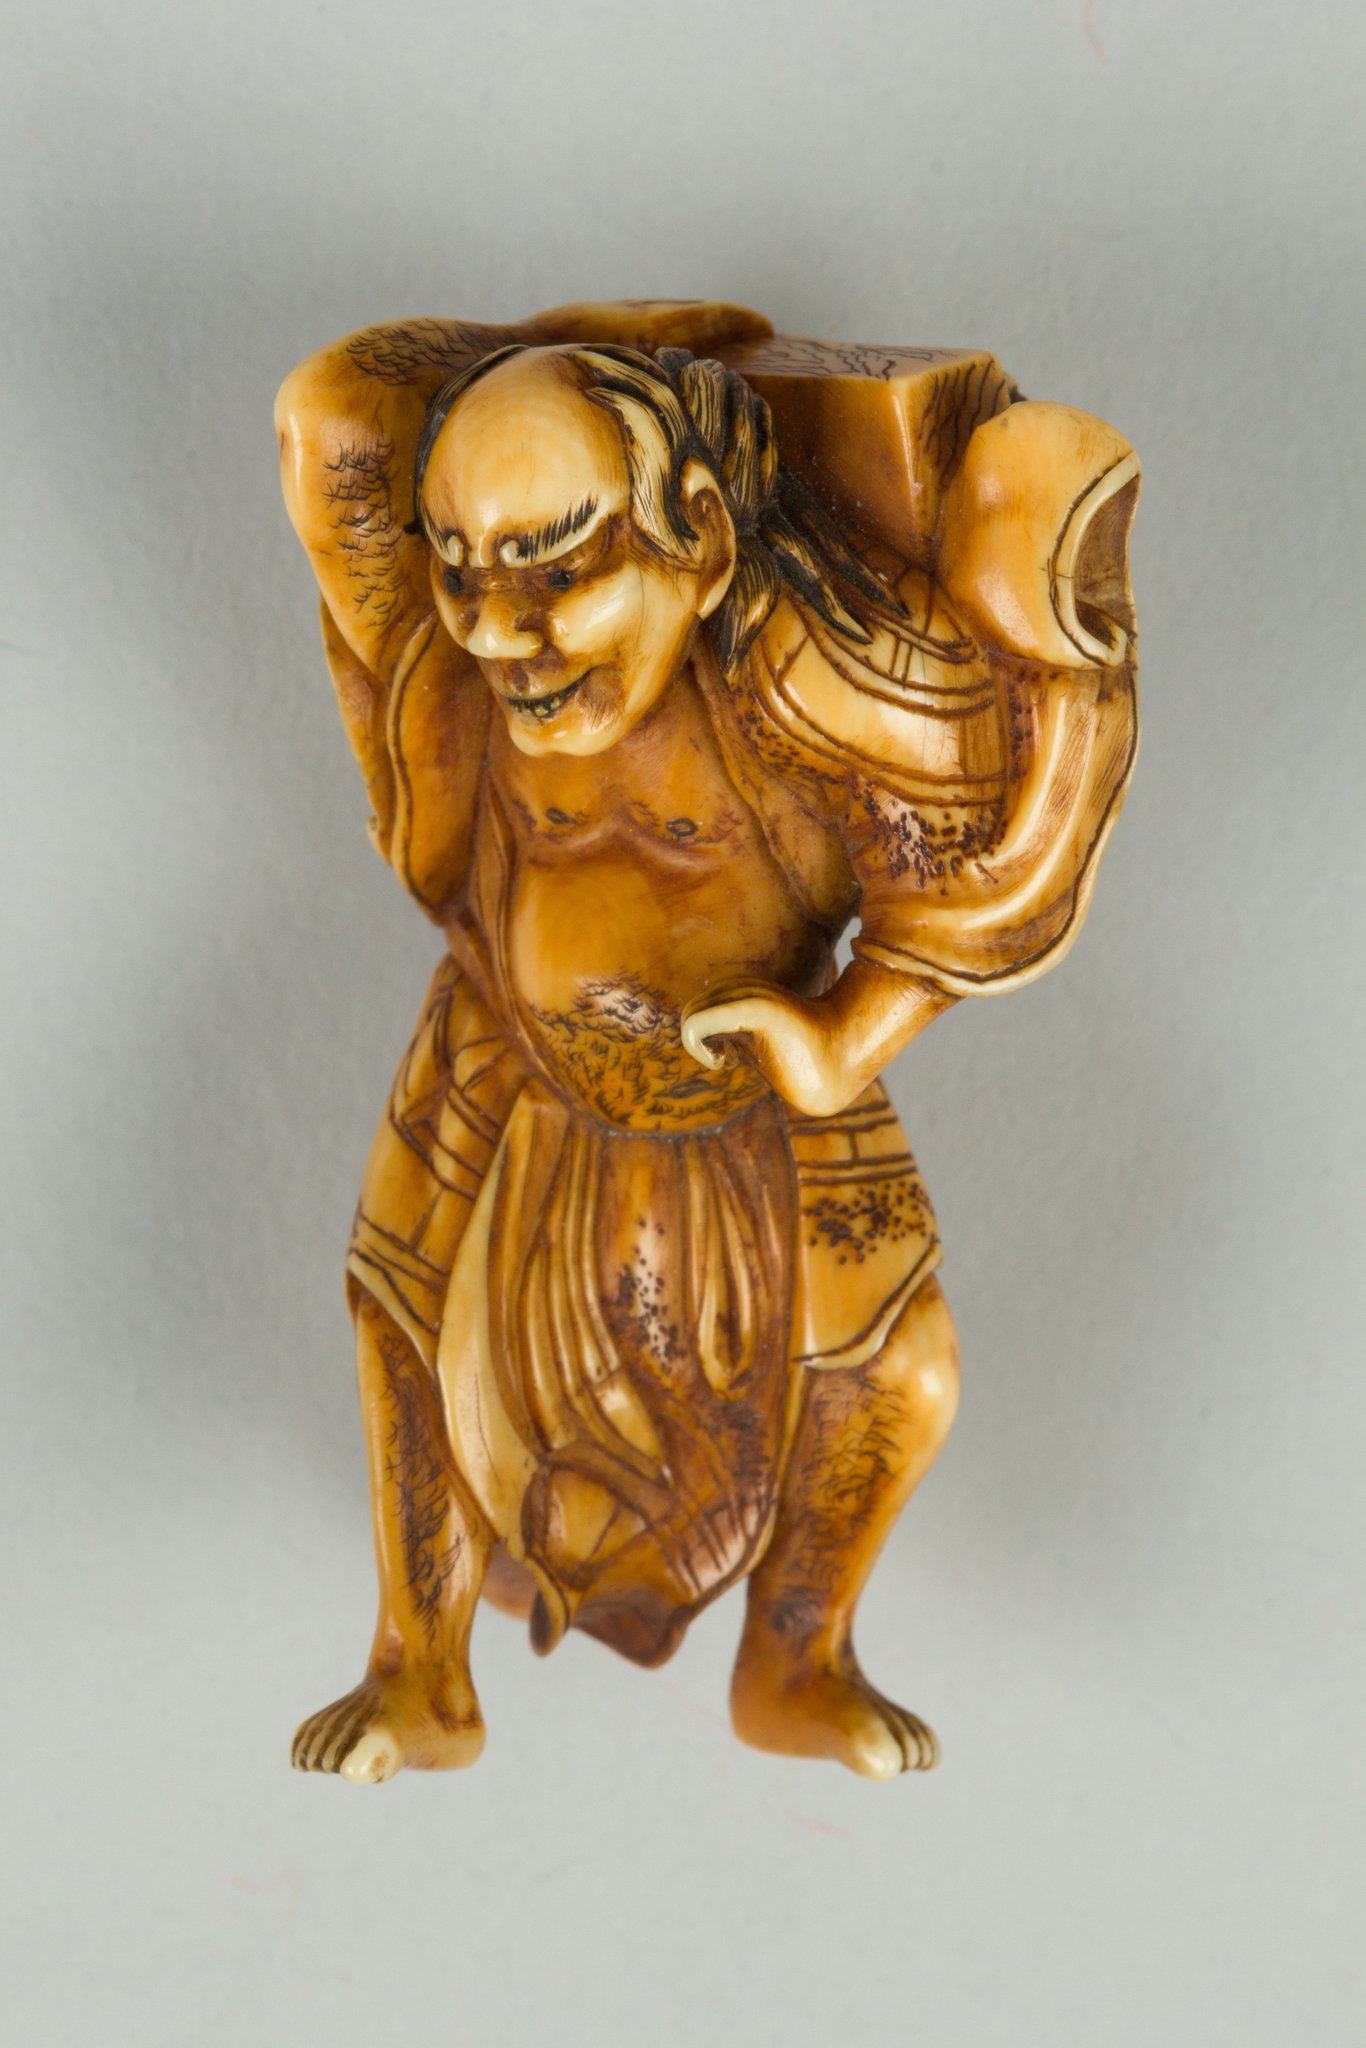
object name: netsuke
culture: japanese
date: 1801-1900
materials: ivory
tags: men